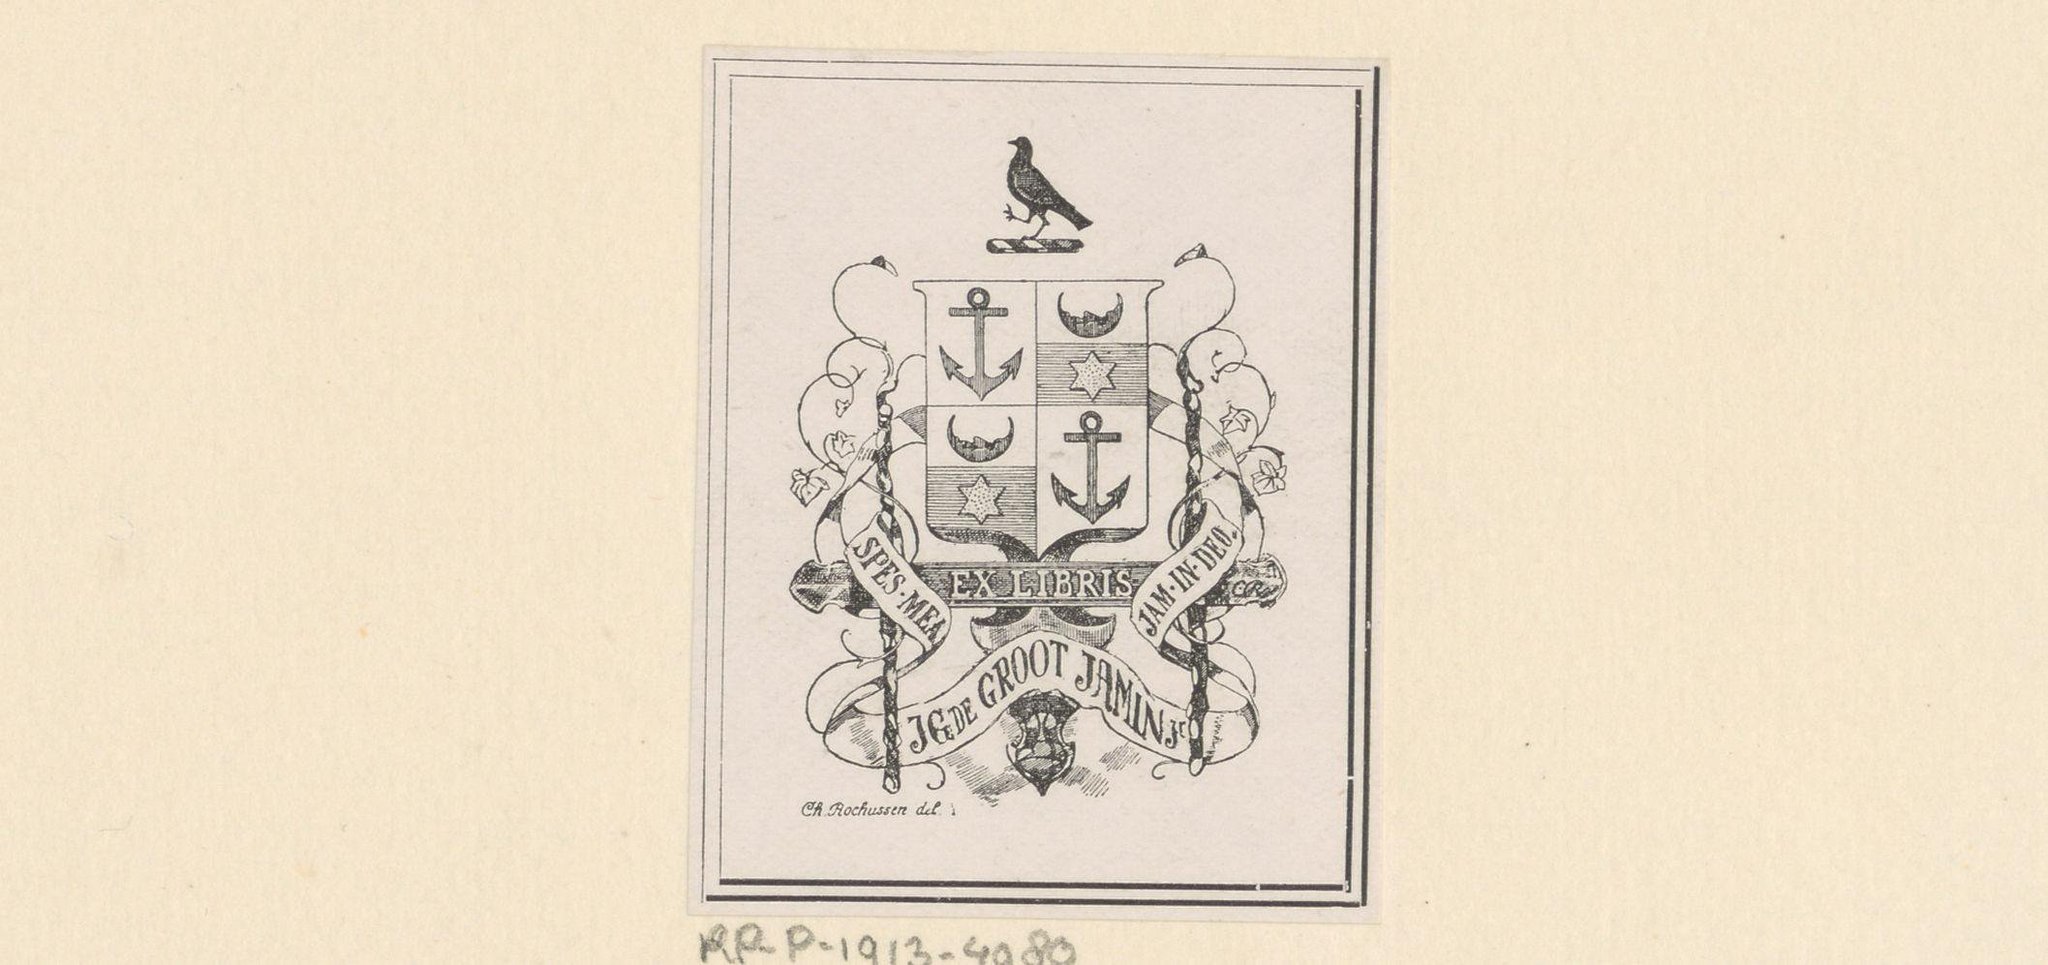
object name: bookplate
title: Ex libris van J.G. de Groot Jamin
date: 1852-1894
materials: paper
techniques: printing block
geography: netherlands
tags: amsterdam, joannes gerardus de groot jamin jr., armorial bearing, heraldry, plants and herbs: ivy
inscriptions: collector's mark: Lugt 2233, collector's mark: Lugt 2760